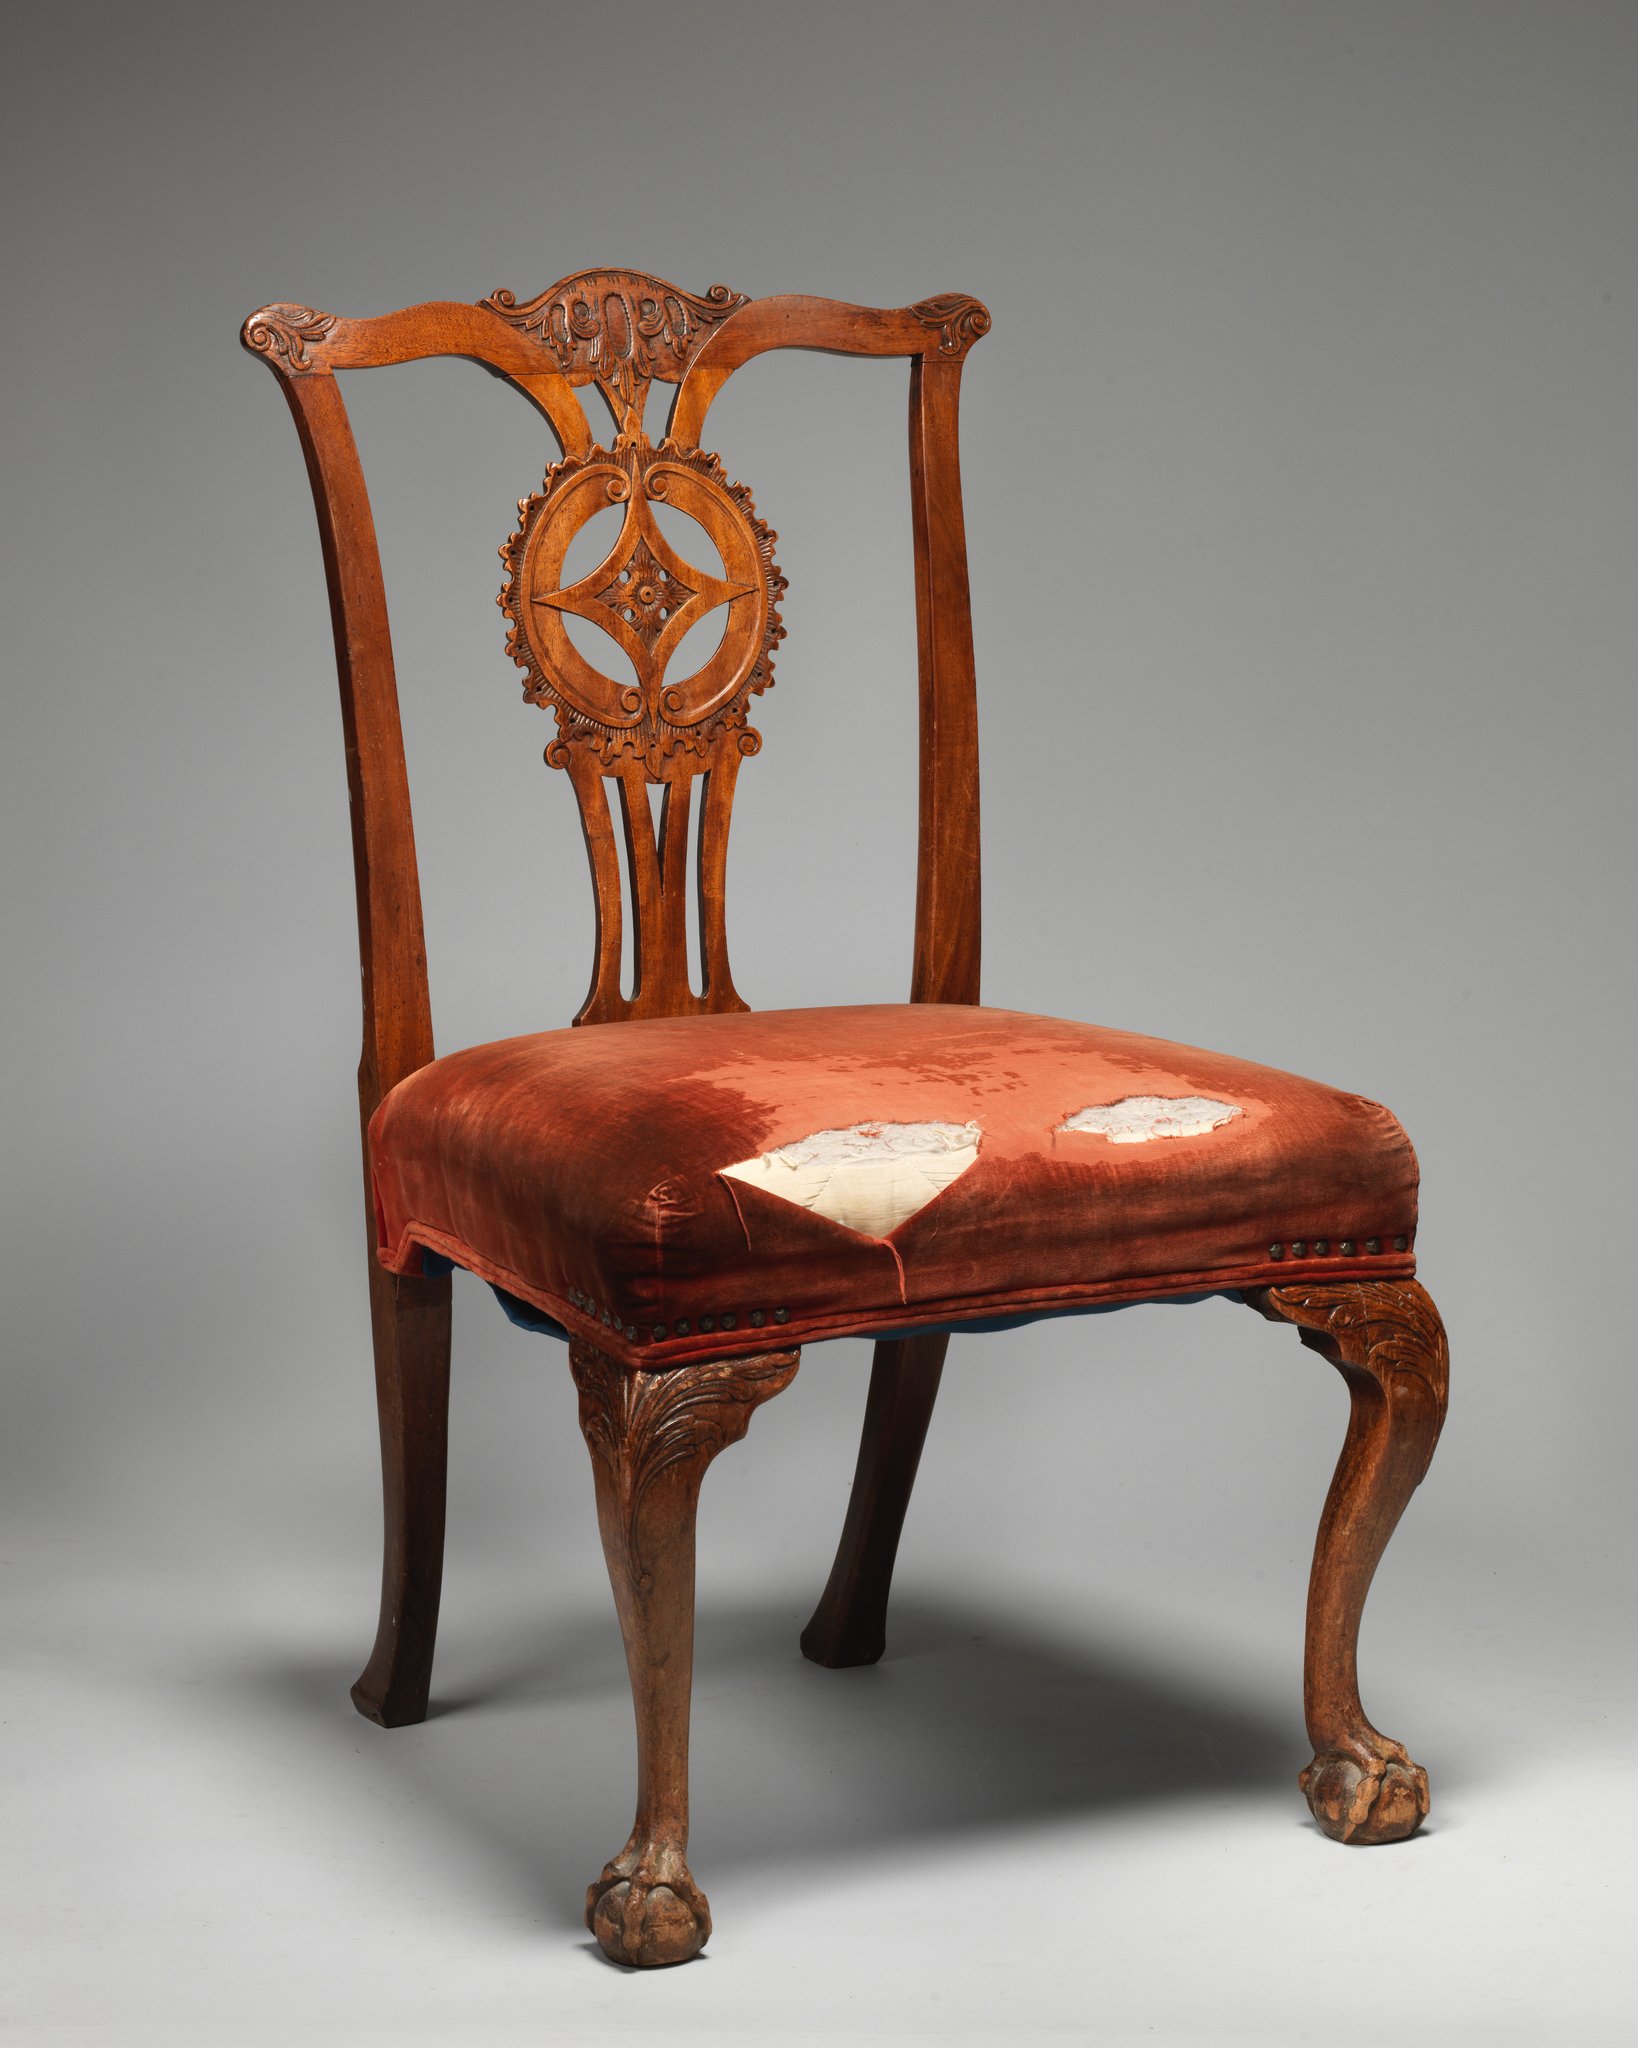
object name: chair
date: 1750-1760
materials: wood